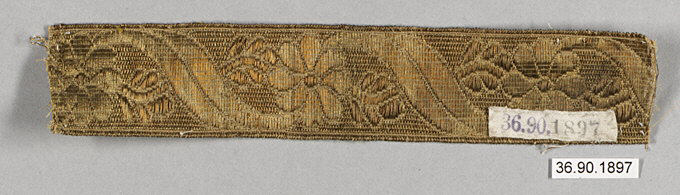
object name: galloon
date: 1767-1900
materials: metal thread, silk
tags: flowers,leaves